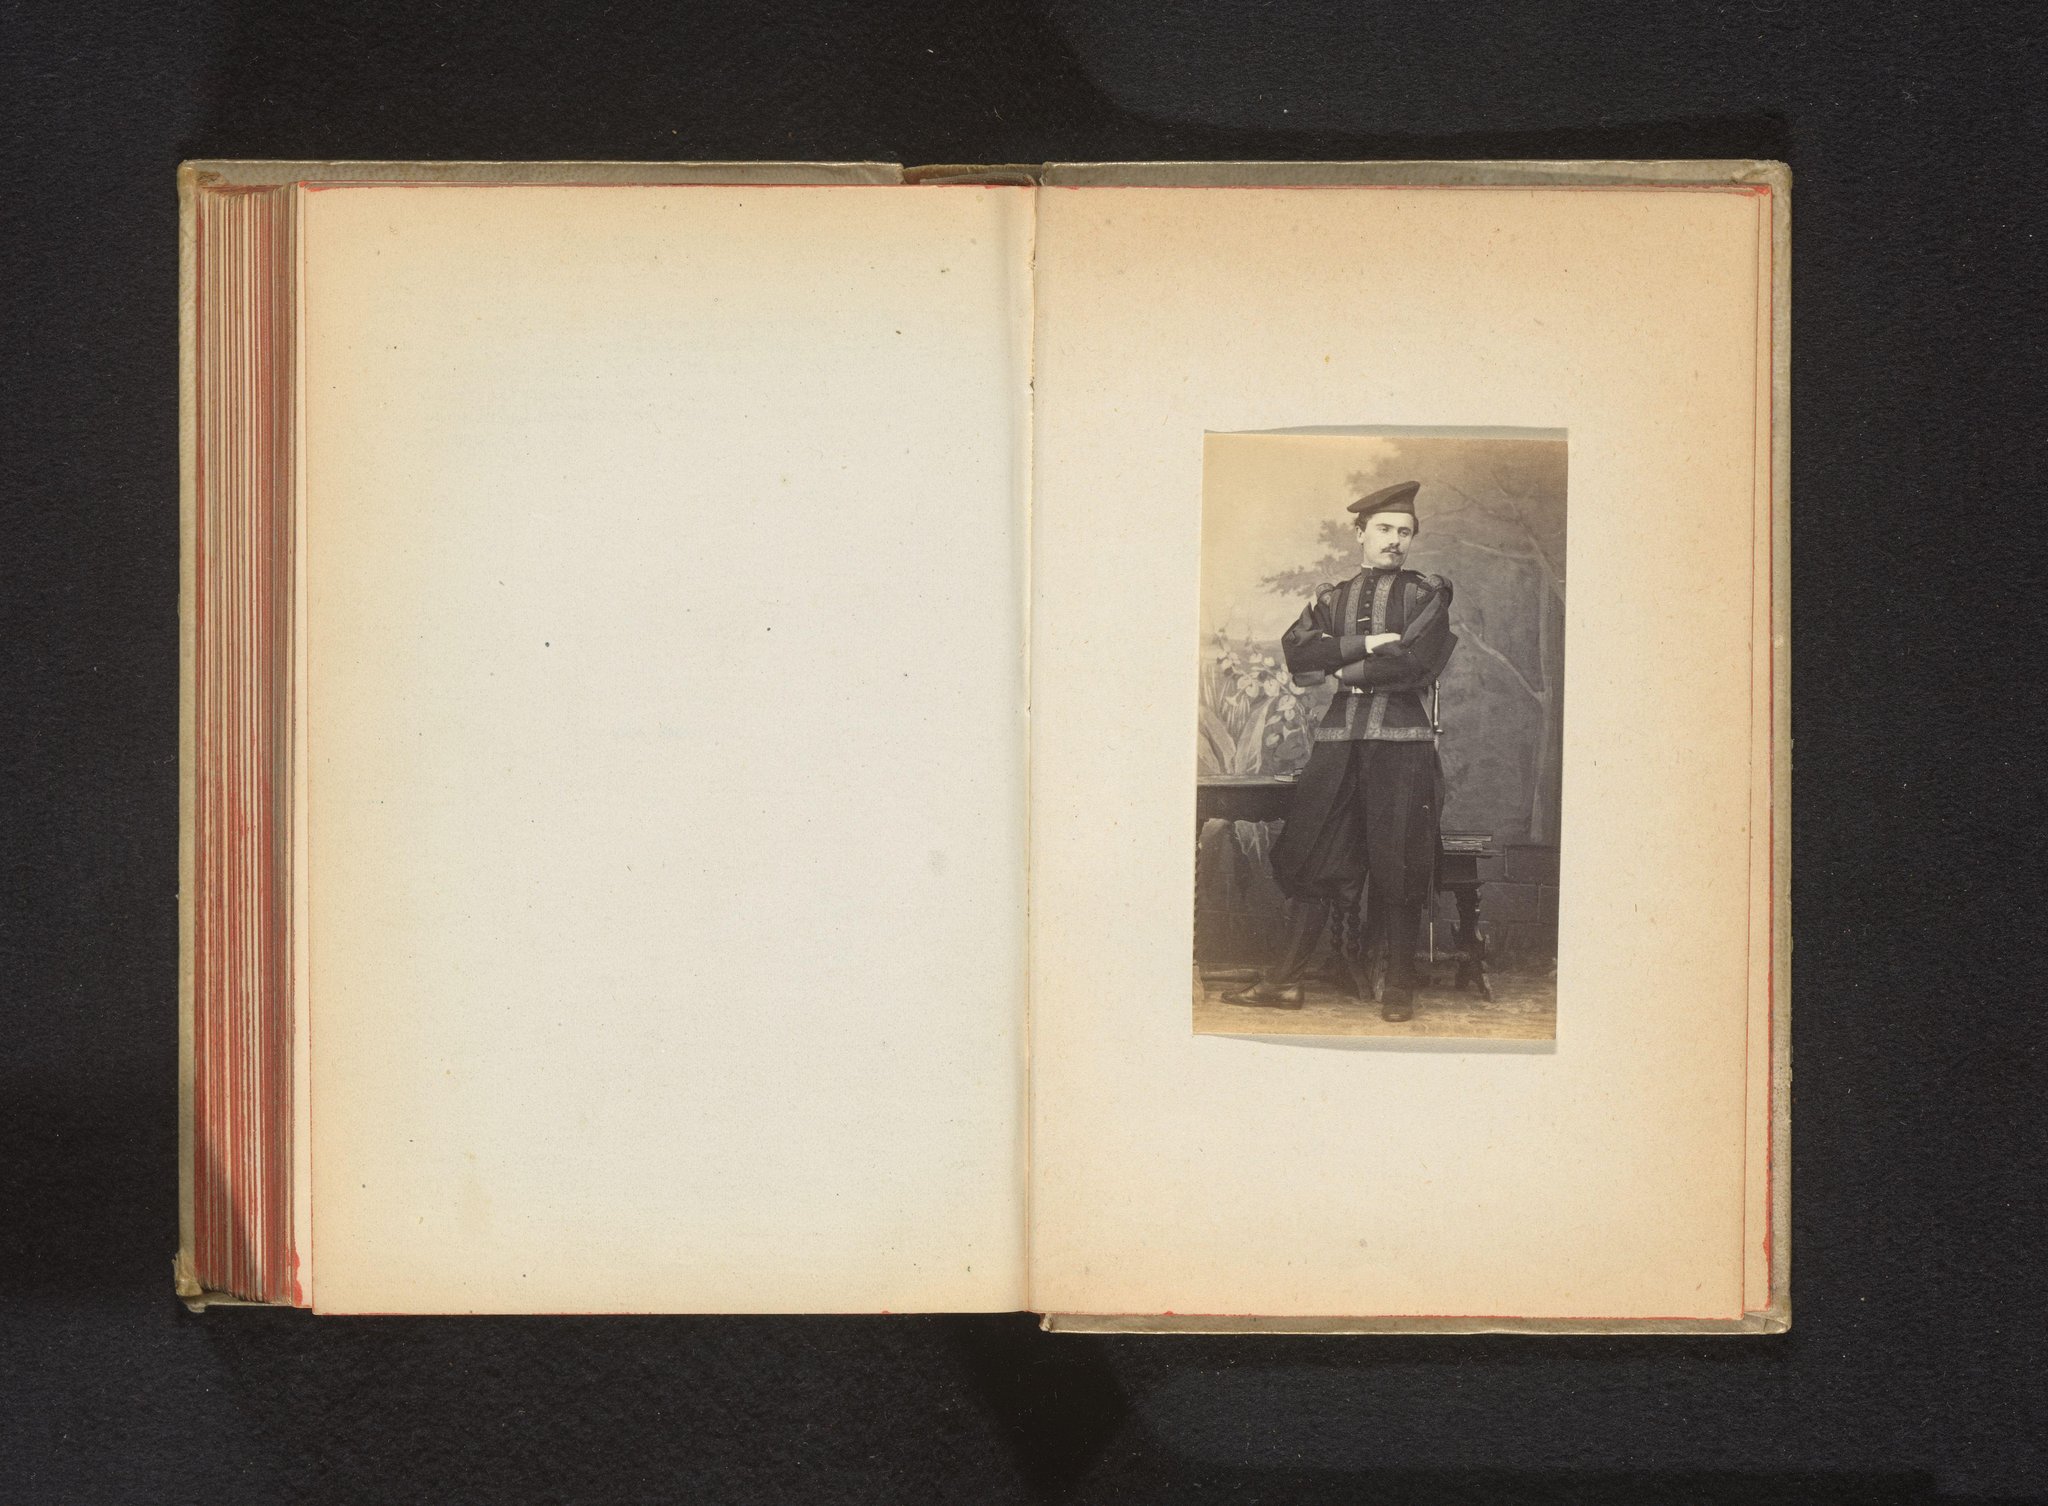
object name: page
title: Portret van een onbekende soldaat van de Zwitserse Garde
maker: Anonymous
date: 1863-1873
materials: photographic support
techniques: albumen print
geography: rome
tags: private soldier